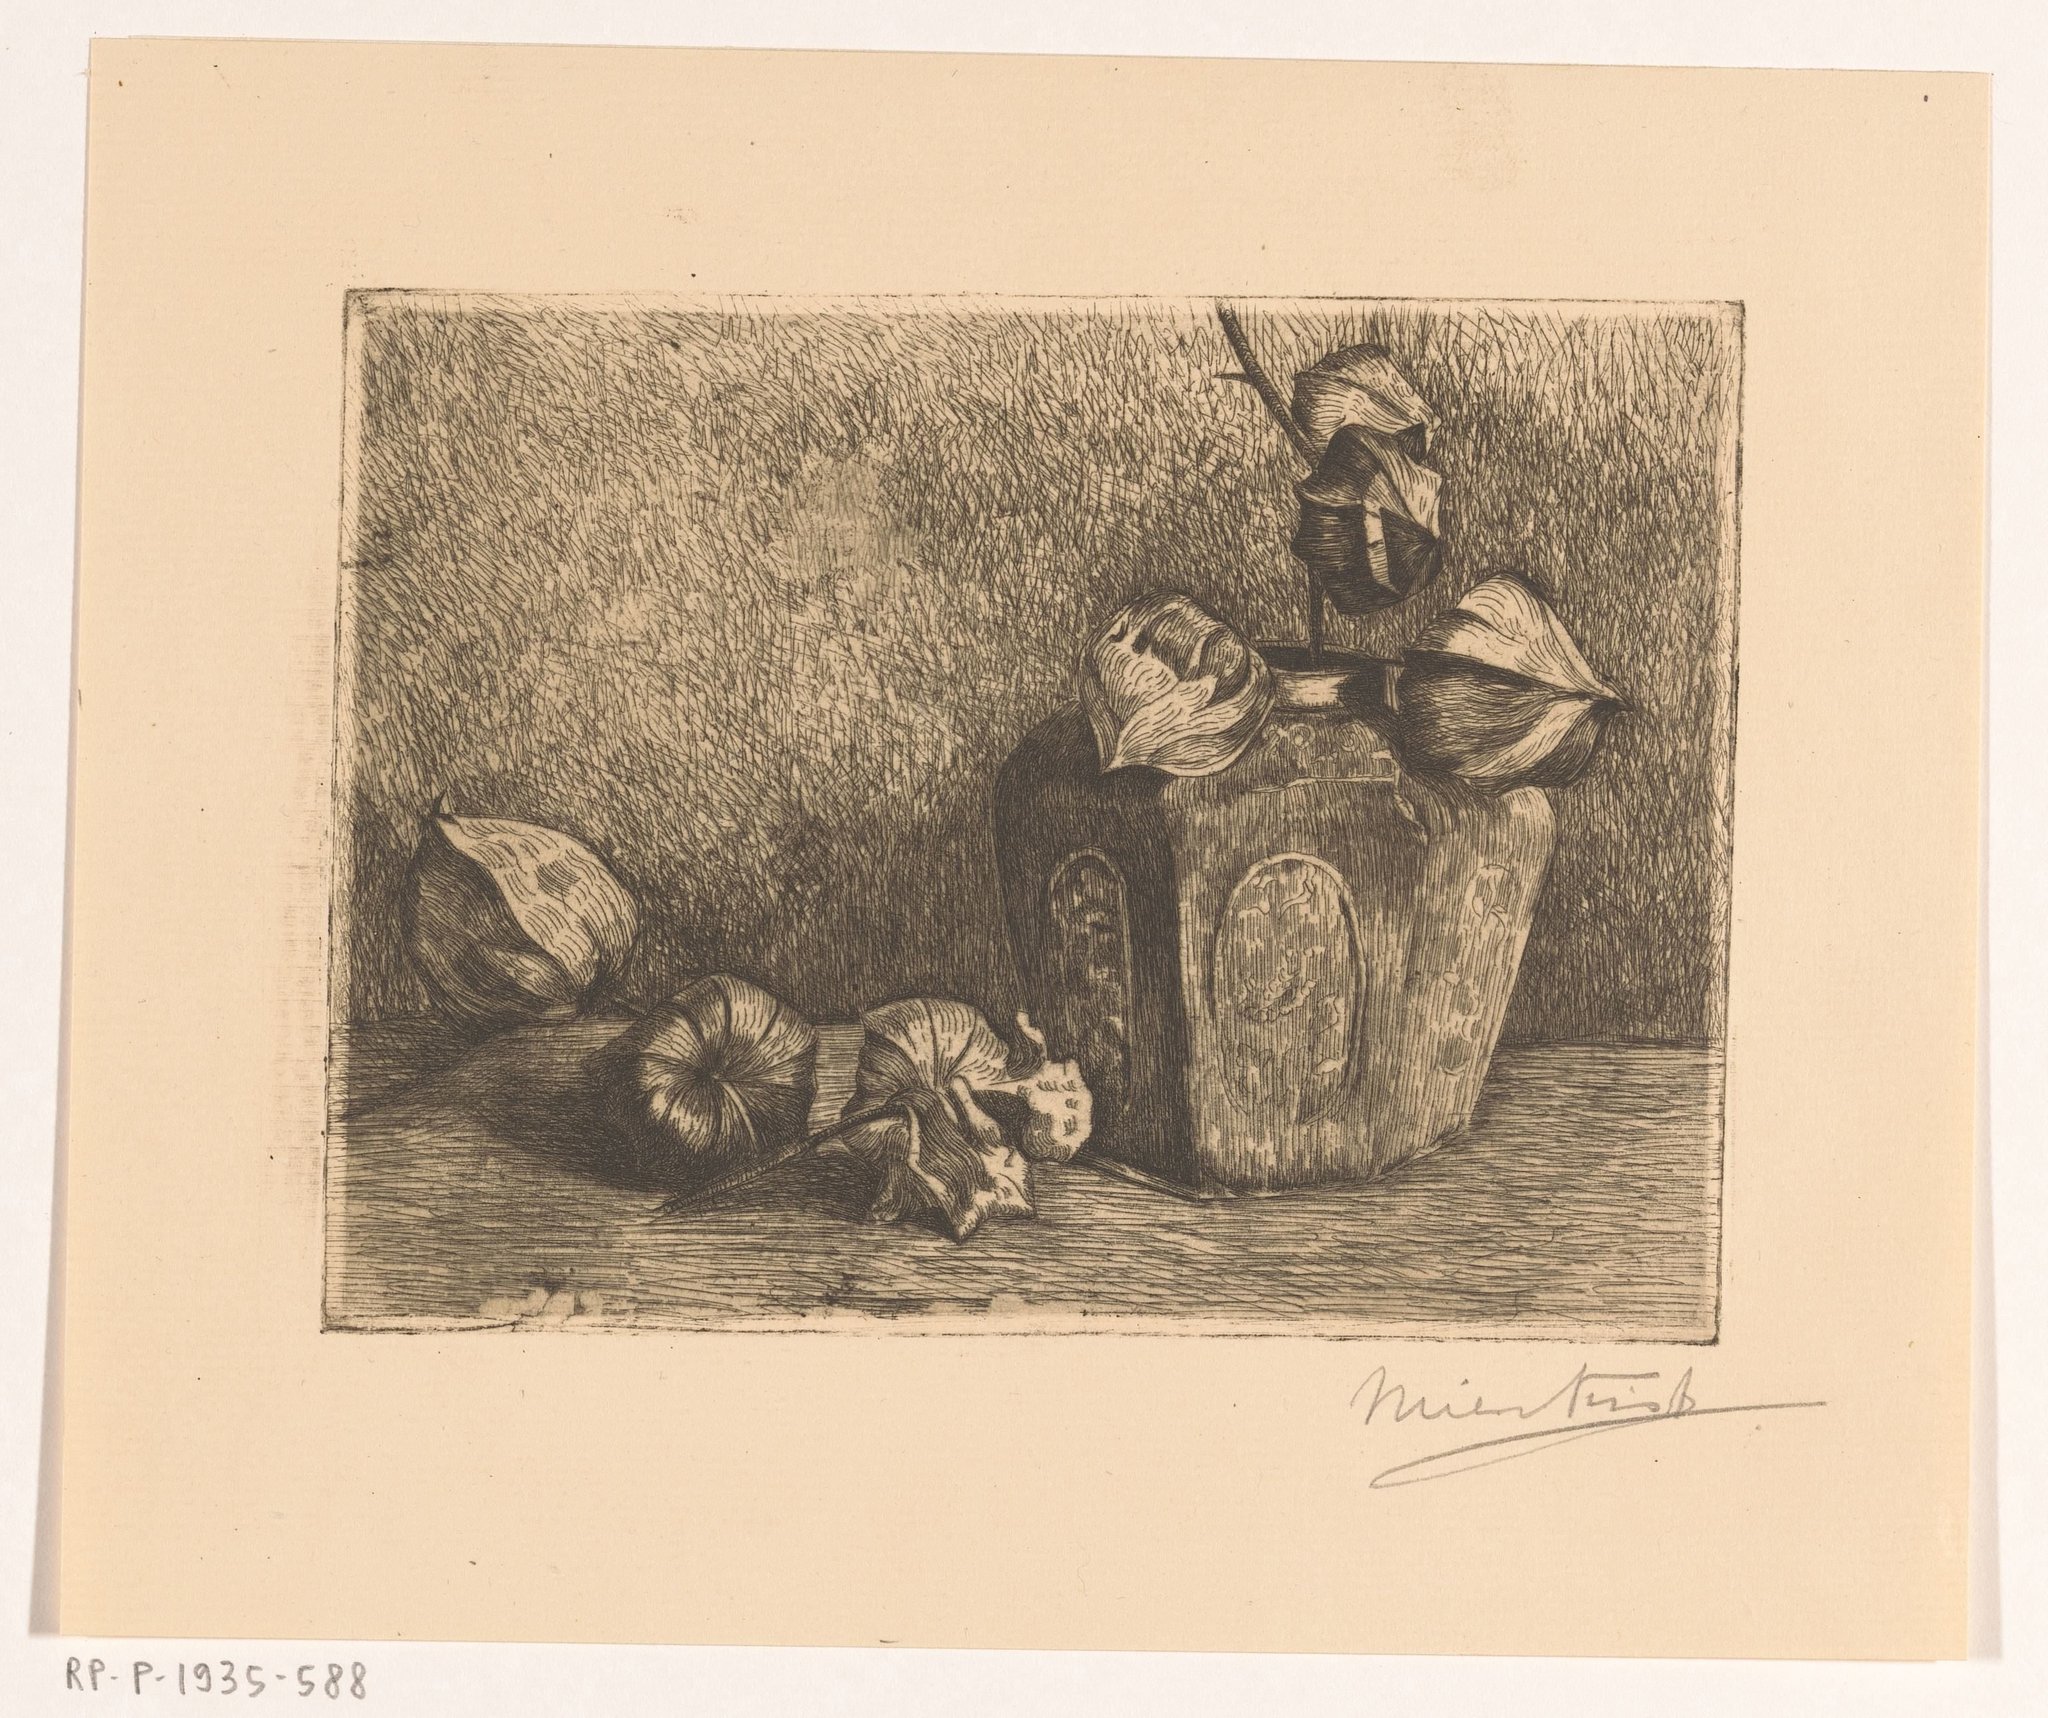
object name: print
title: Stilleven met gemberpot en lampionplant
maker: wilhelmine kist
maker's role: print maker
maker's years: 1891-1950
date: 1901-1935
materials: paper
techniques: etching, intaglio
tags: still life of miscellaneous objects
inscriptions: collector's mark: Lugt 2760, collector's mark: Lugt 2228